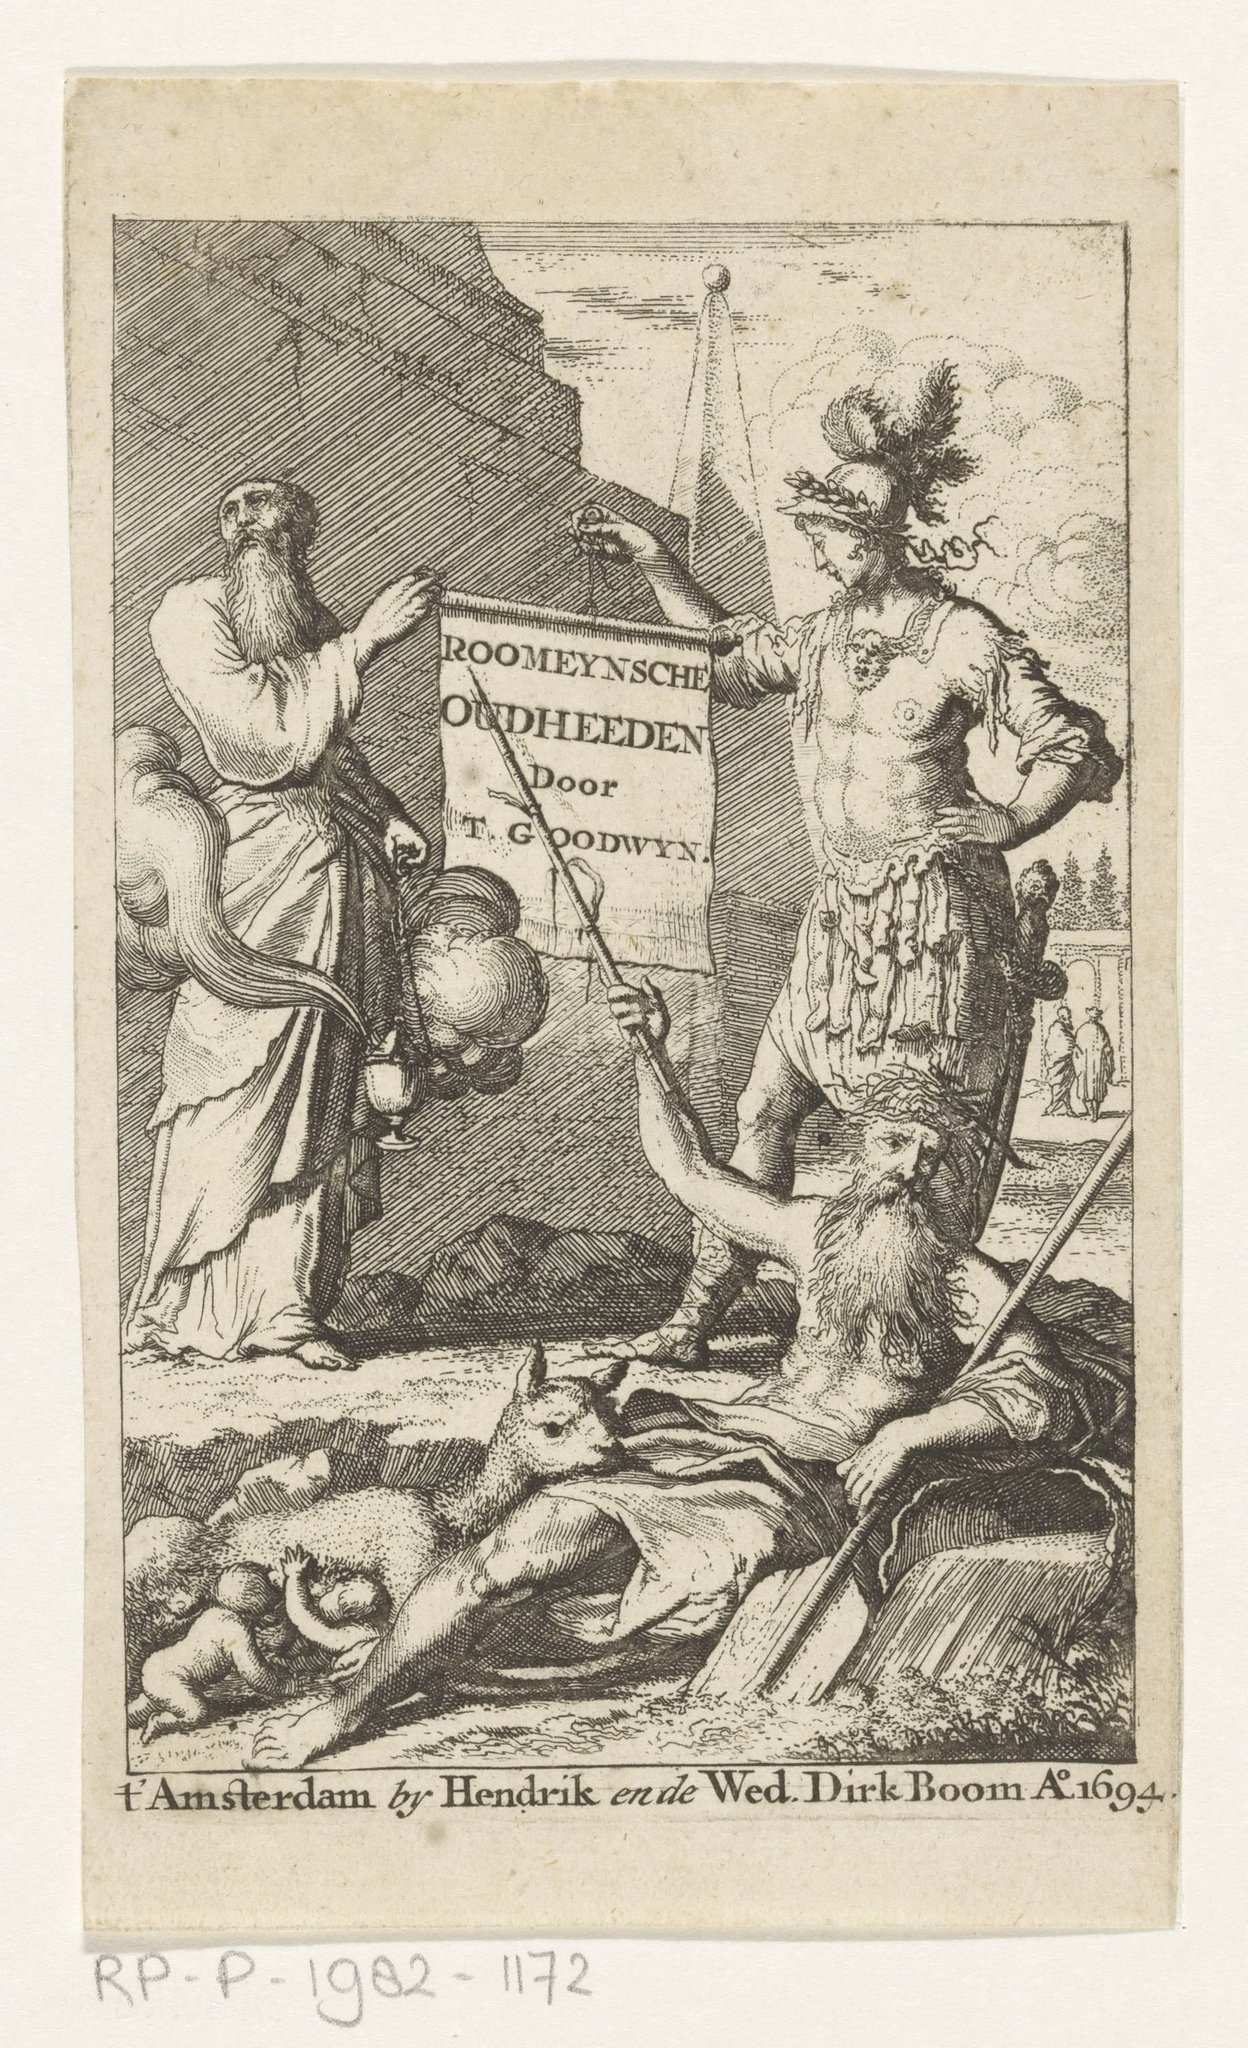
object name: print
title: Romeinse soldaat en een priester houden geopende rol vast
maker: jan luyken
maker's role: draughtsman, print maker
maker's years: 1649-1712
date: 1694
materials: paper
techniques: etching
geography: amsterdam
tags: priest (roman catholic), river-gods, (story of) romulus and remus, extinct, 'historical' peoples (with name)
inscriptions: collector's mark: Lugt 2228, collector's mark: Lugt 2760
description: Titelpagina voor: Goodwyn, Thomas. Romanae historiae, anthologia recognita & aucta. Een Engelsche uytlegginge van de Romeynsche oudheden. Amsterdam: Boom, Hendrick en Weduwe Dirk, 1694.